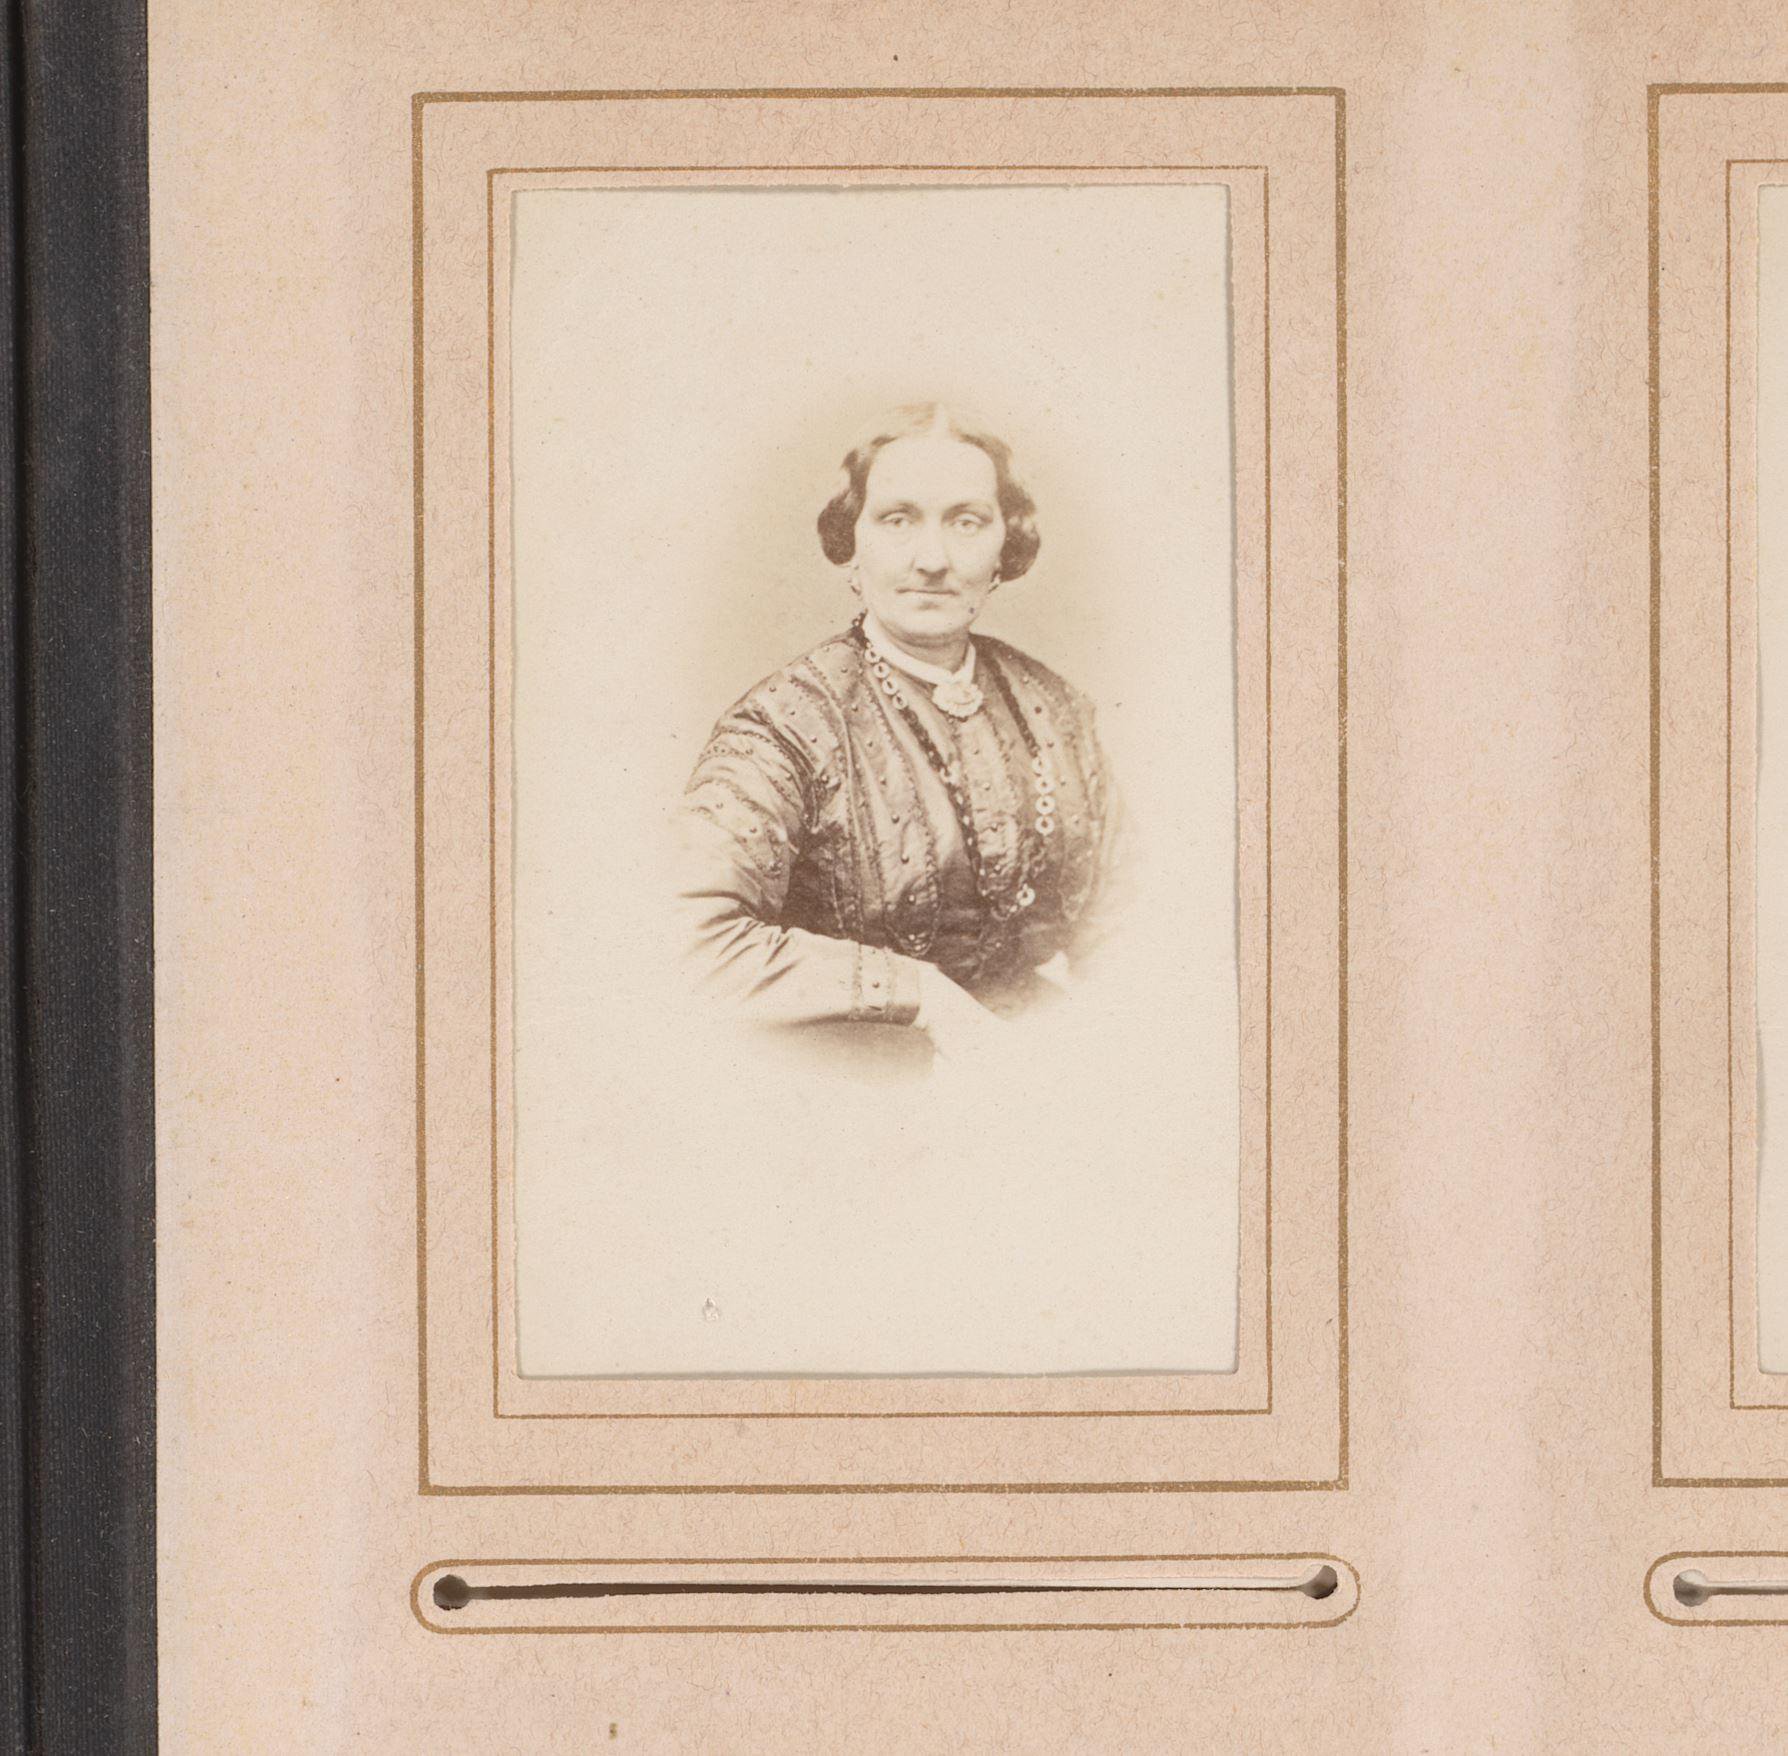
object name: photograph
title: Portret van een vrouw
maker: albert greiner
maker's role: fotograaf, fotostudio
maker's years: 1833-1890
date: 1861-1874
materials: cardboard, photographic support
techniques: albumen print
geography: amsterdam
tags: historical persons - bb - woman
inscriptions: inscription: ‘A. Greiner/ Photograf/ Nieuwendijk L.87/ Amsterdam’